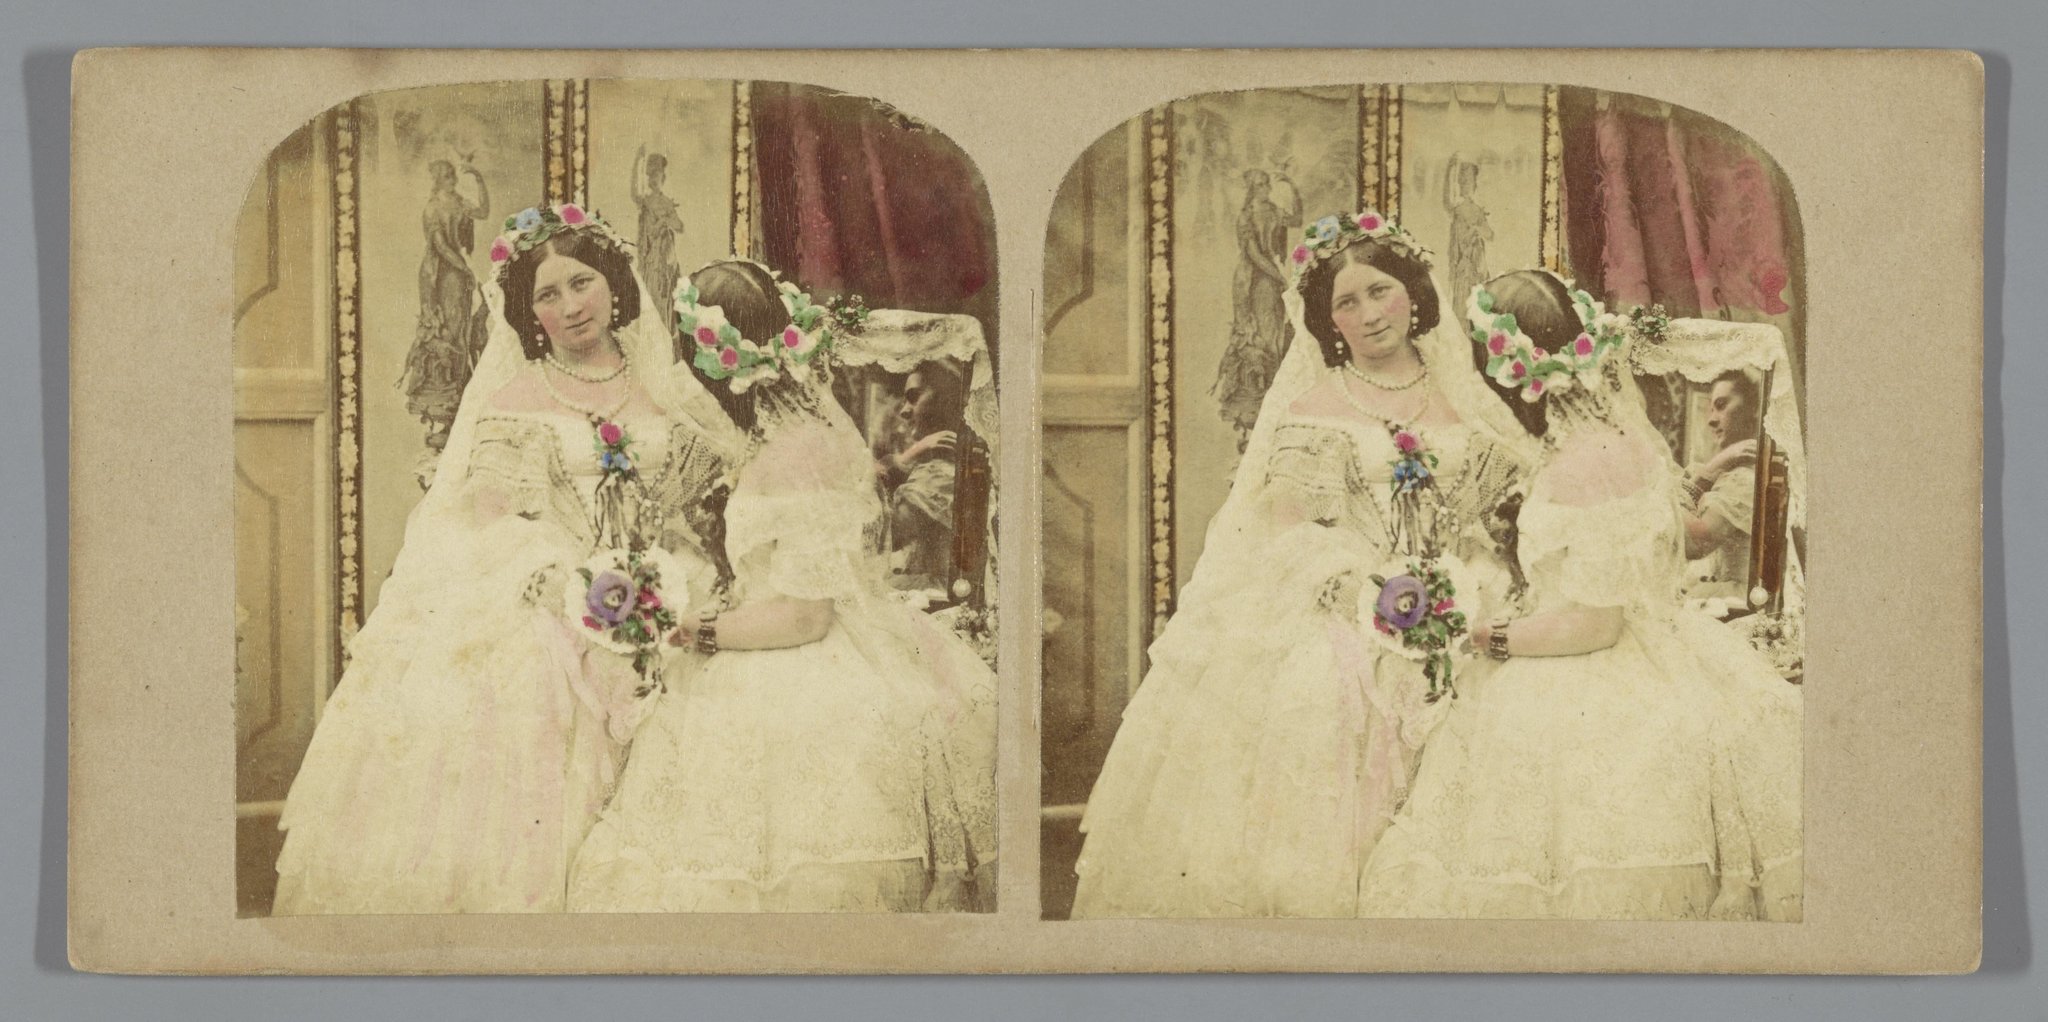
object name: stereograph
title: The Bride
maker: Anonymous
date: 1852-1863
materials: cardboard, paper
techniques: albumen print, hand coloring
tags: bride (in wedding-dress)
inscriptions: inscription: ‘J. C. MEERBURG,’, stamp: ‘S. A. MEERBURG/ LEIJDEN’, inscription: ‘15’